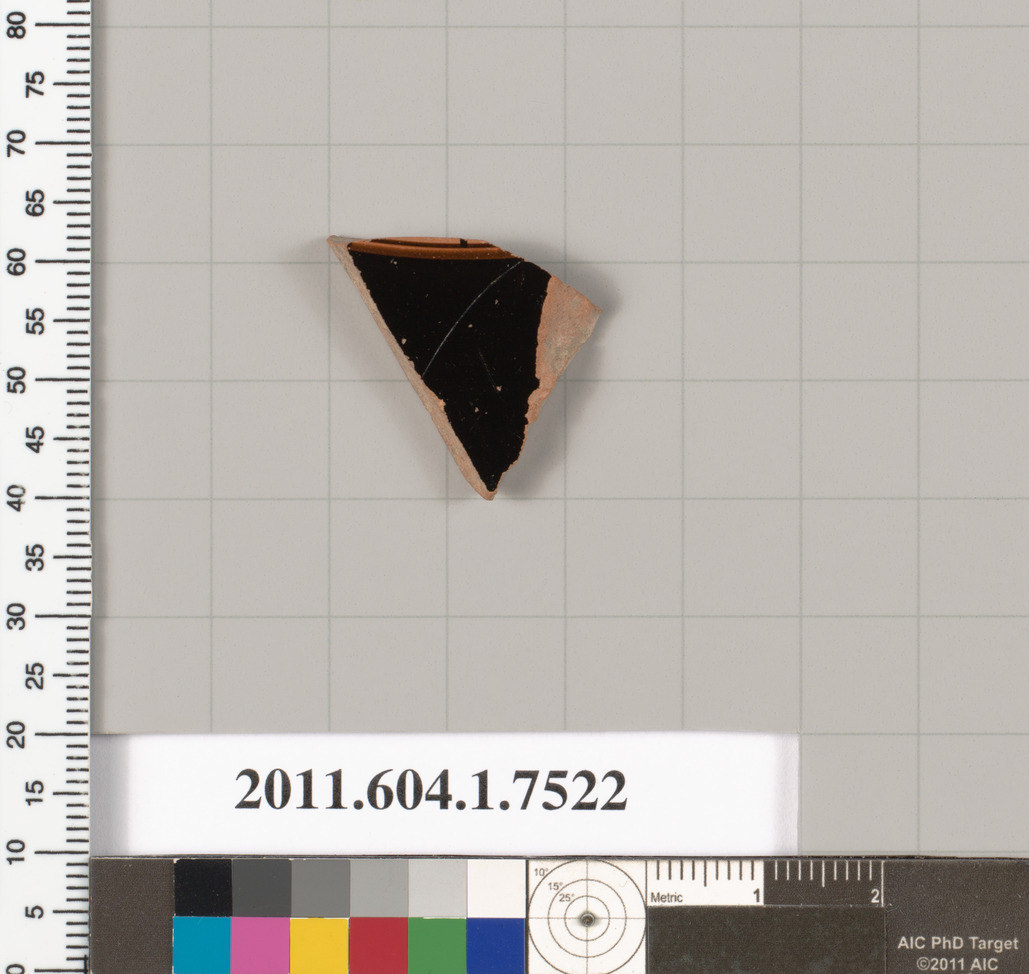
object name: kylix fragment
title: Terracotta fragment of a kylix (drinking cup)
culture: greek, attic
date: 460-450 BCE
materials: terracotta